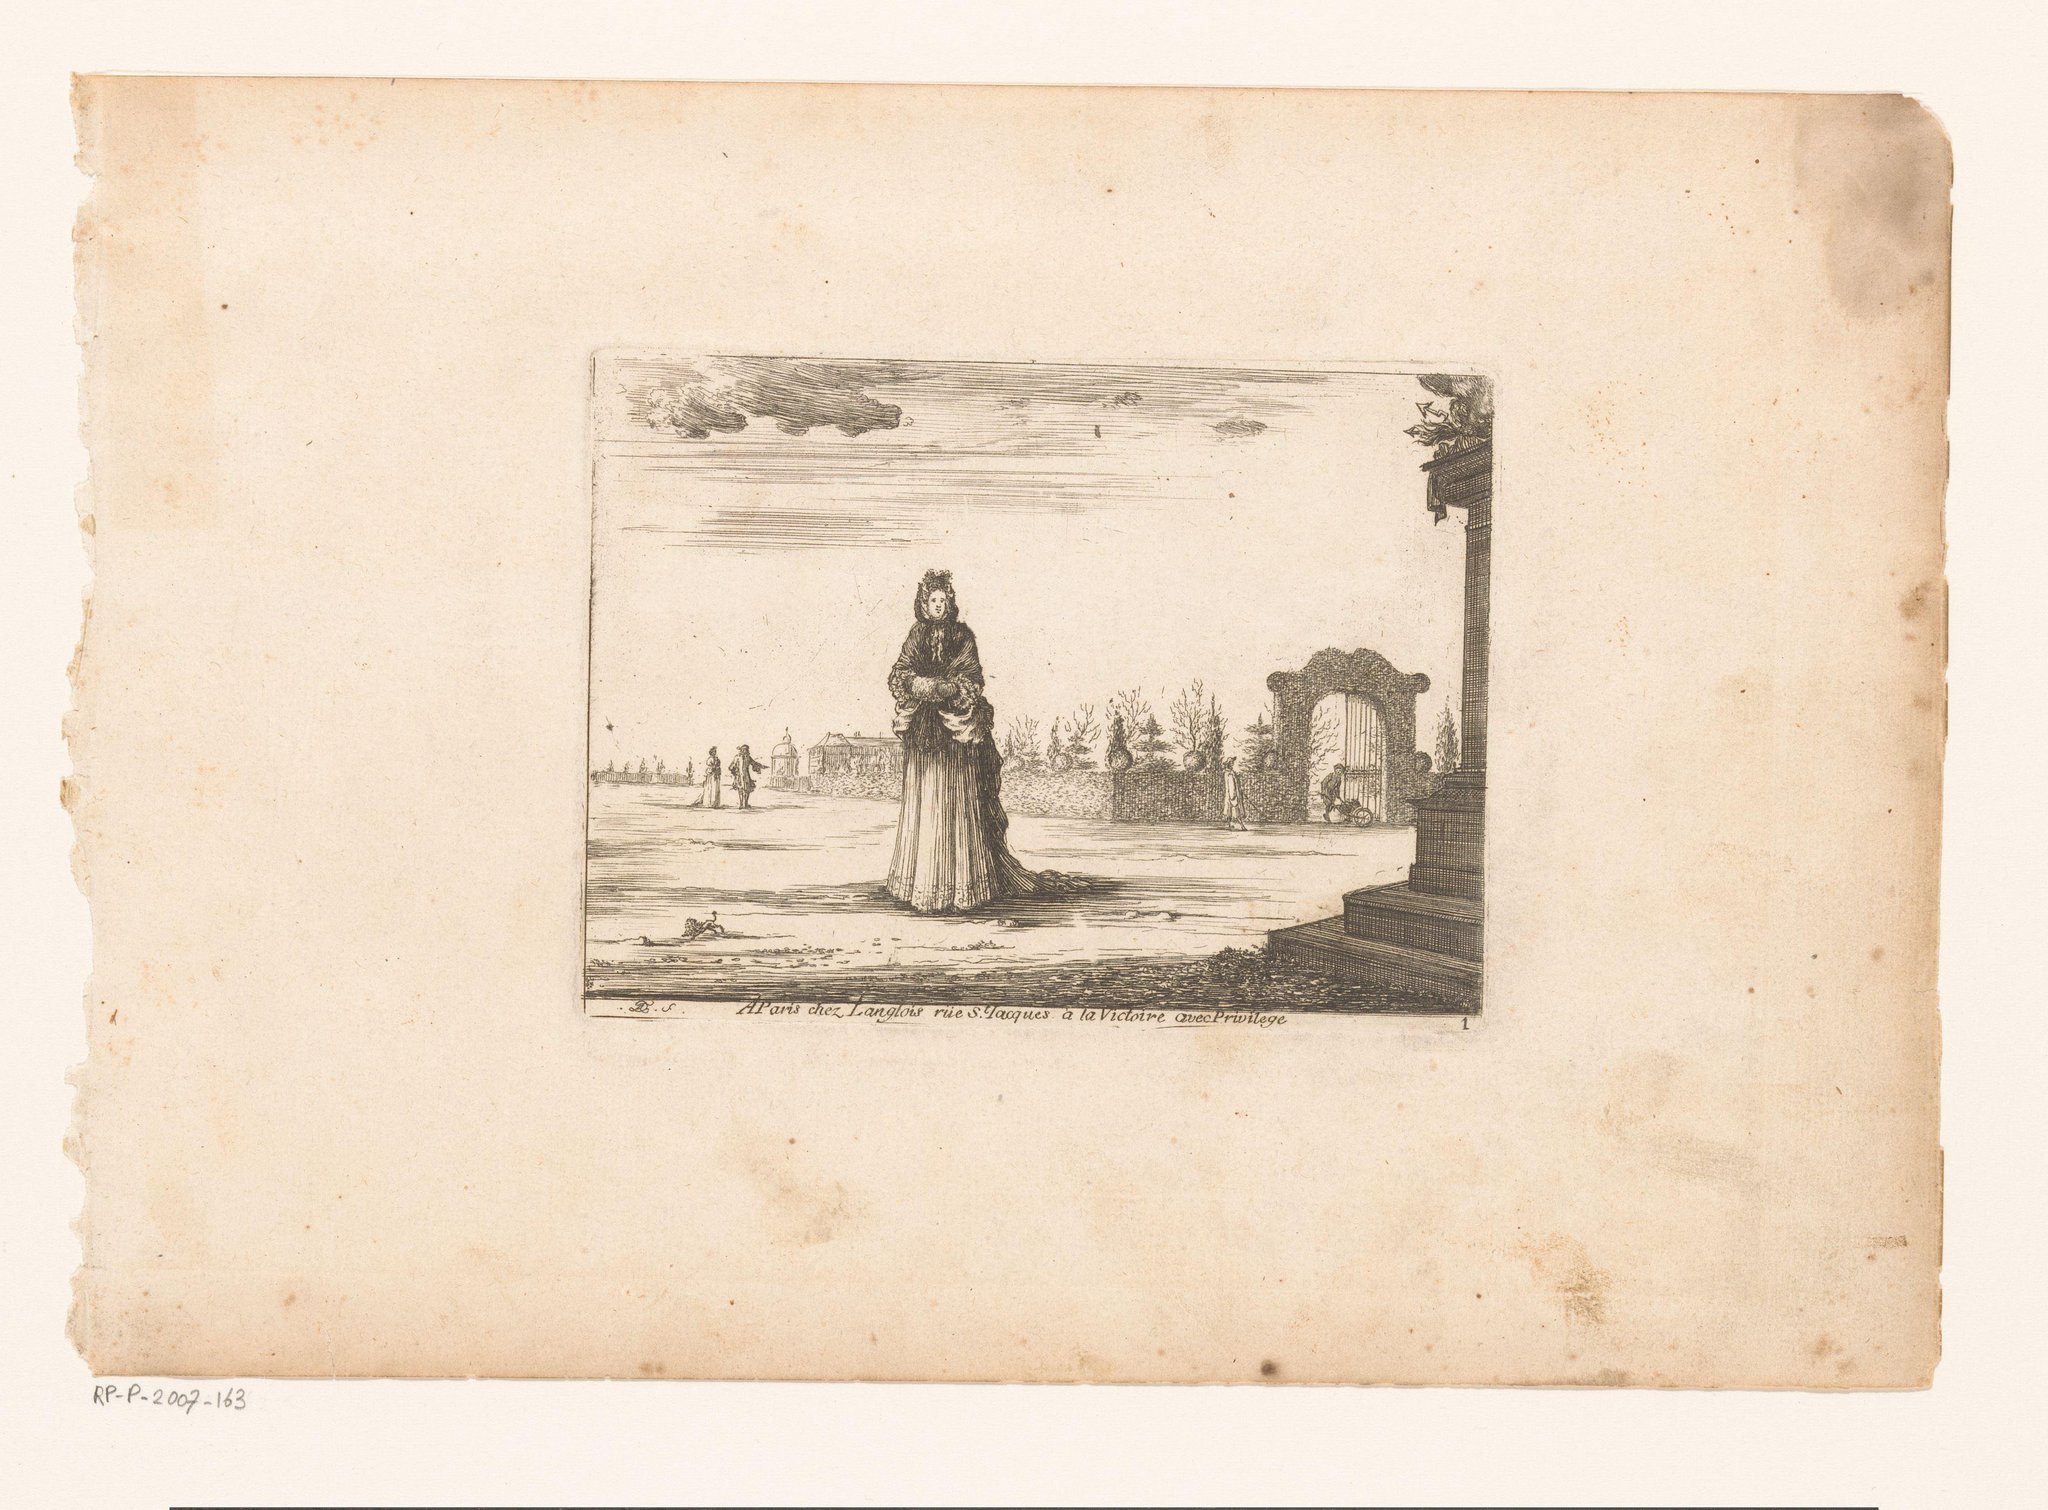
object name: print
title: Diverses figures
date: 1670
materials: paper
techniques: etching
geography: paris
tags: adult woman, muff, garden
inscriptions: collector's mark: Lugt 2228, collector's mark: Lugt 2760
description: Maakt deel uit van een serie van twaalf prenten met verschillende figuren, uitgegeven door Langlois in Parijs.